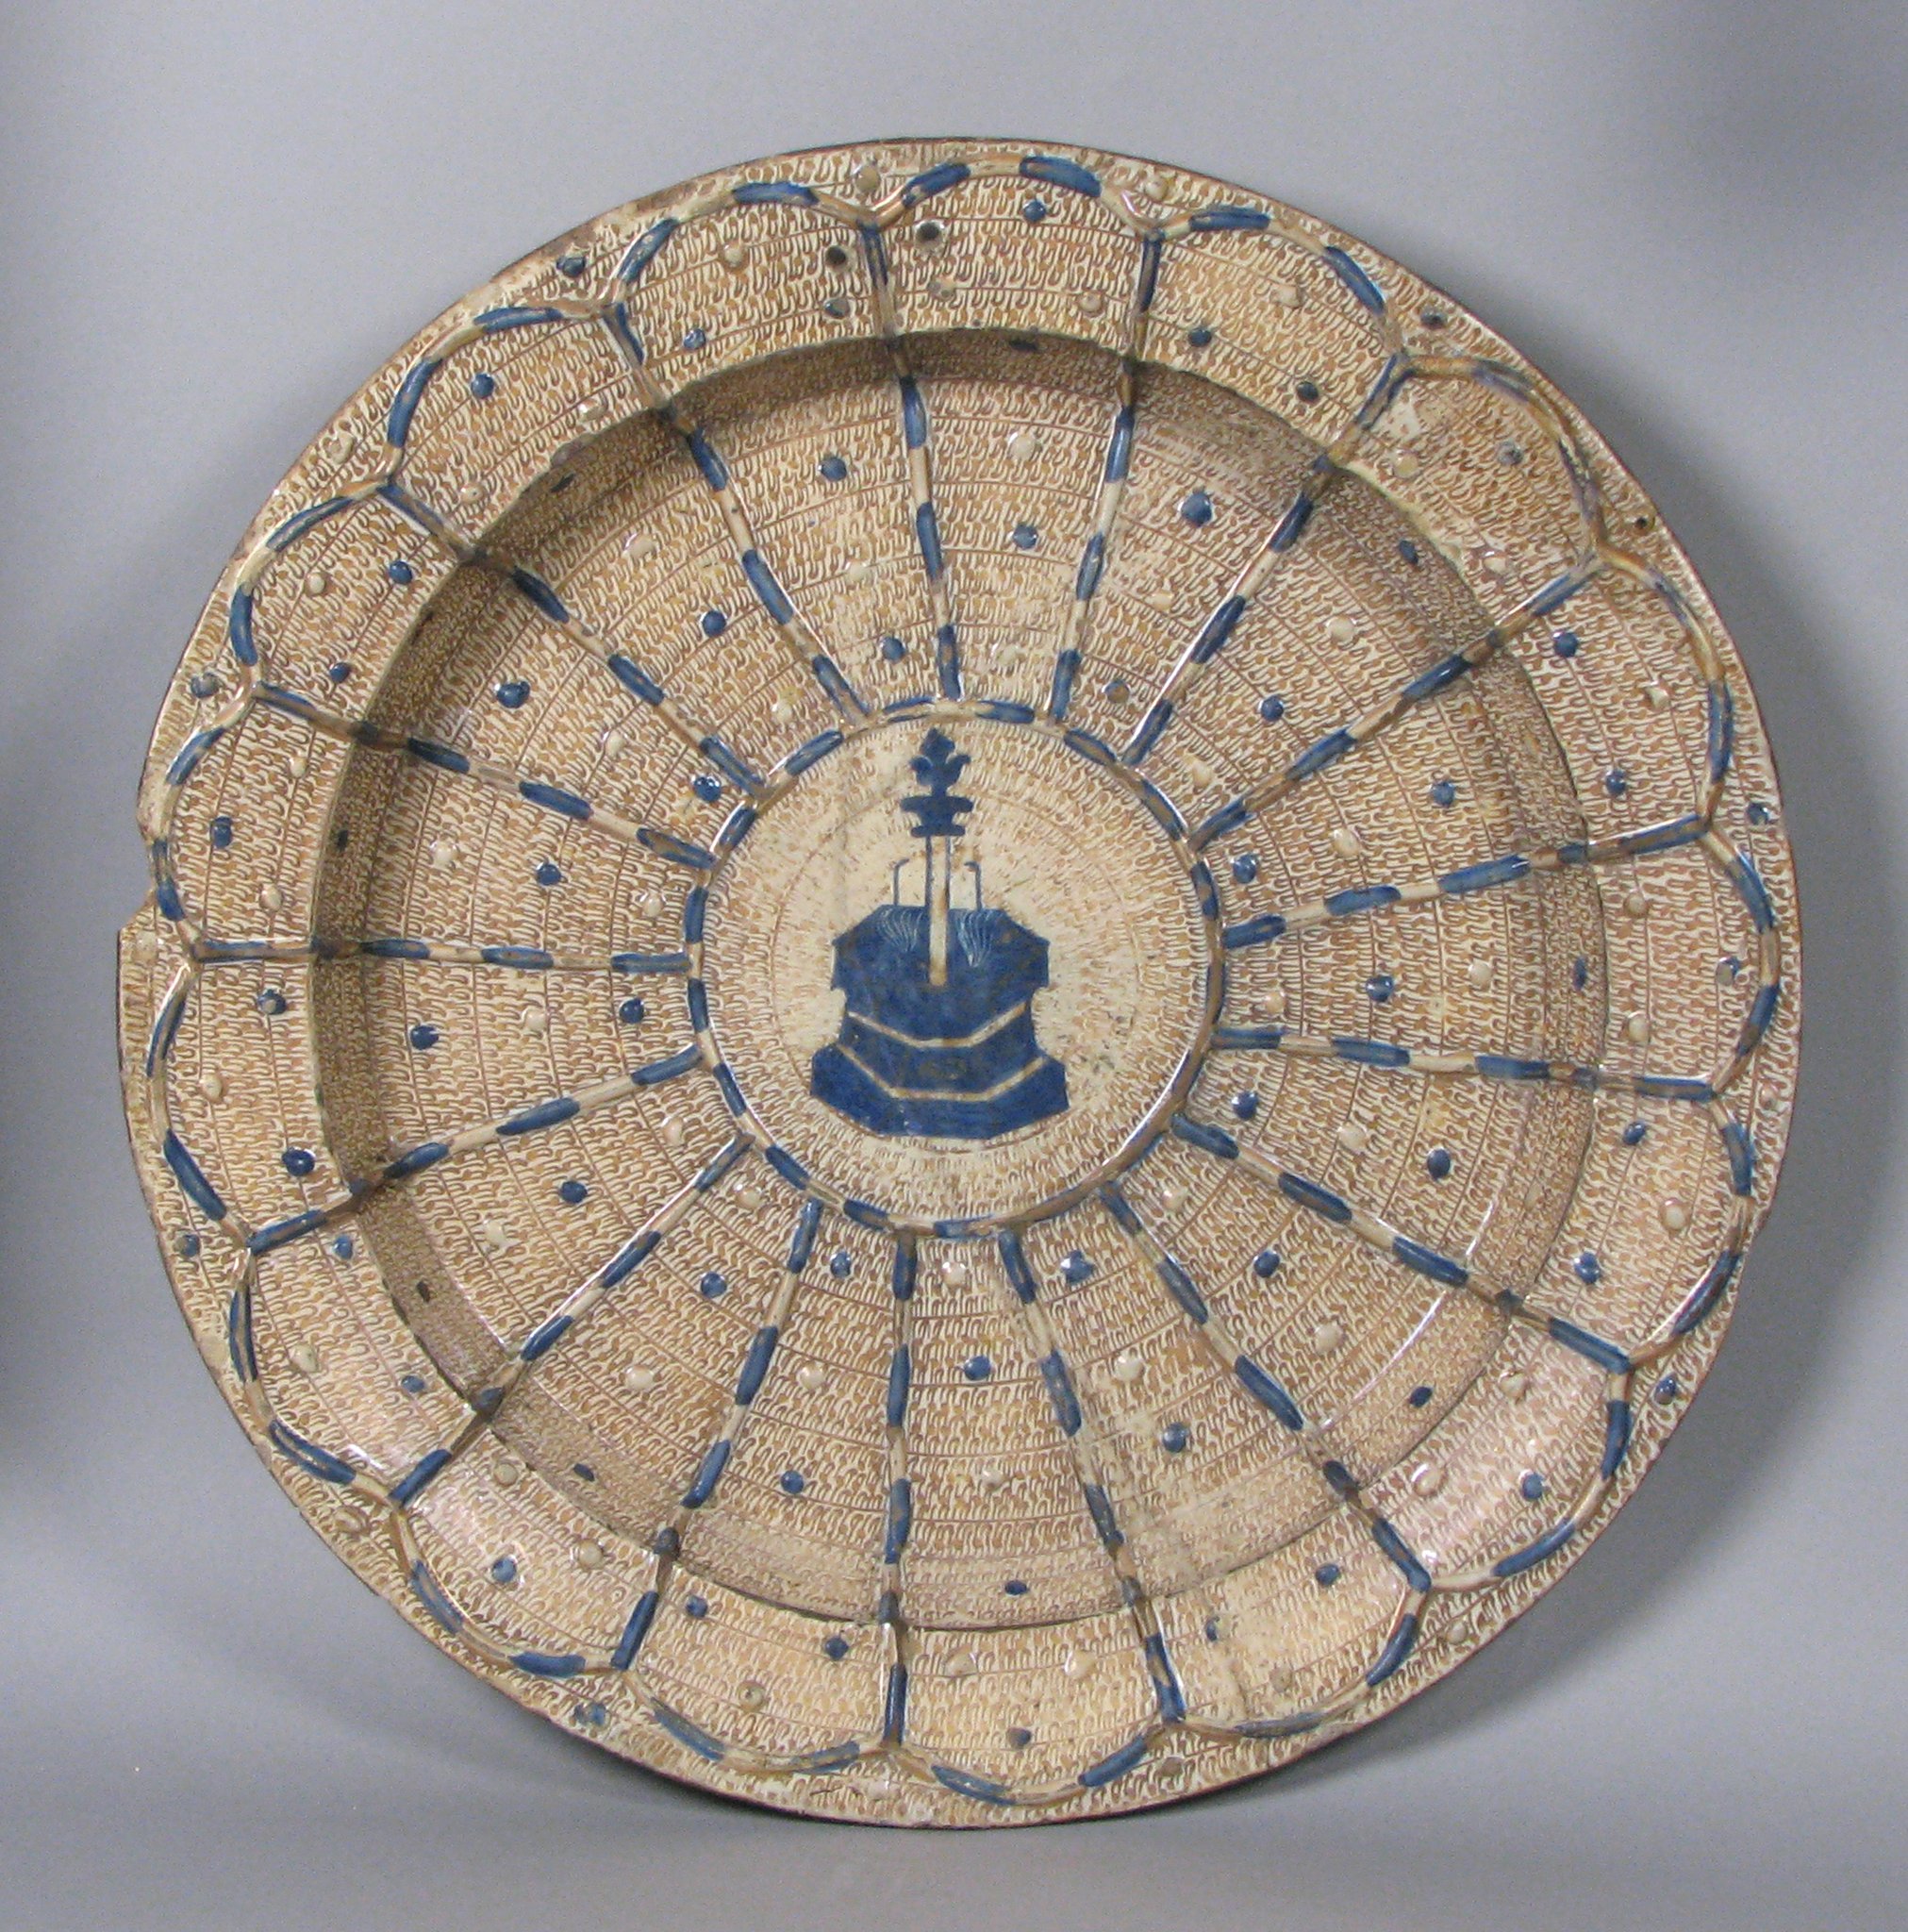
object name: dish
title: Deep Dish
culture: spanish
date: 1490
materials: earthenware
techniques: glazing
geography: spain